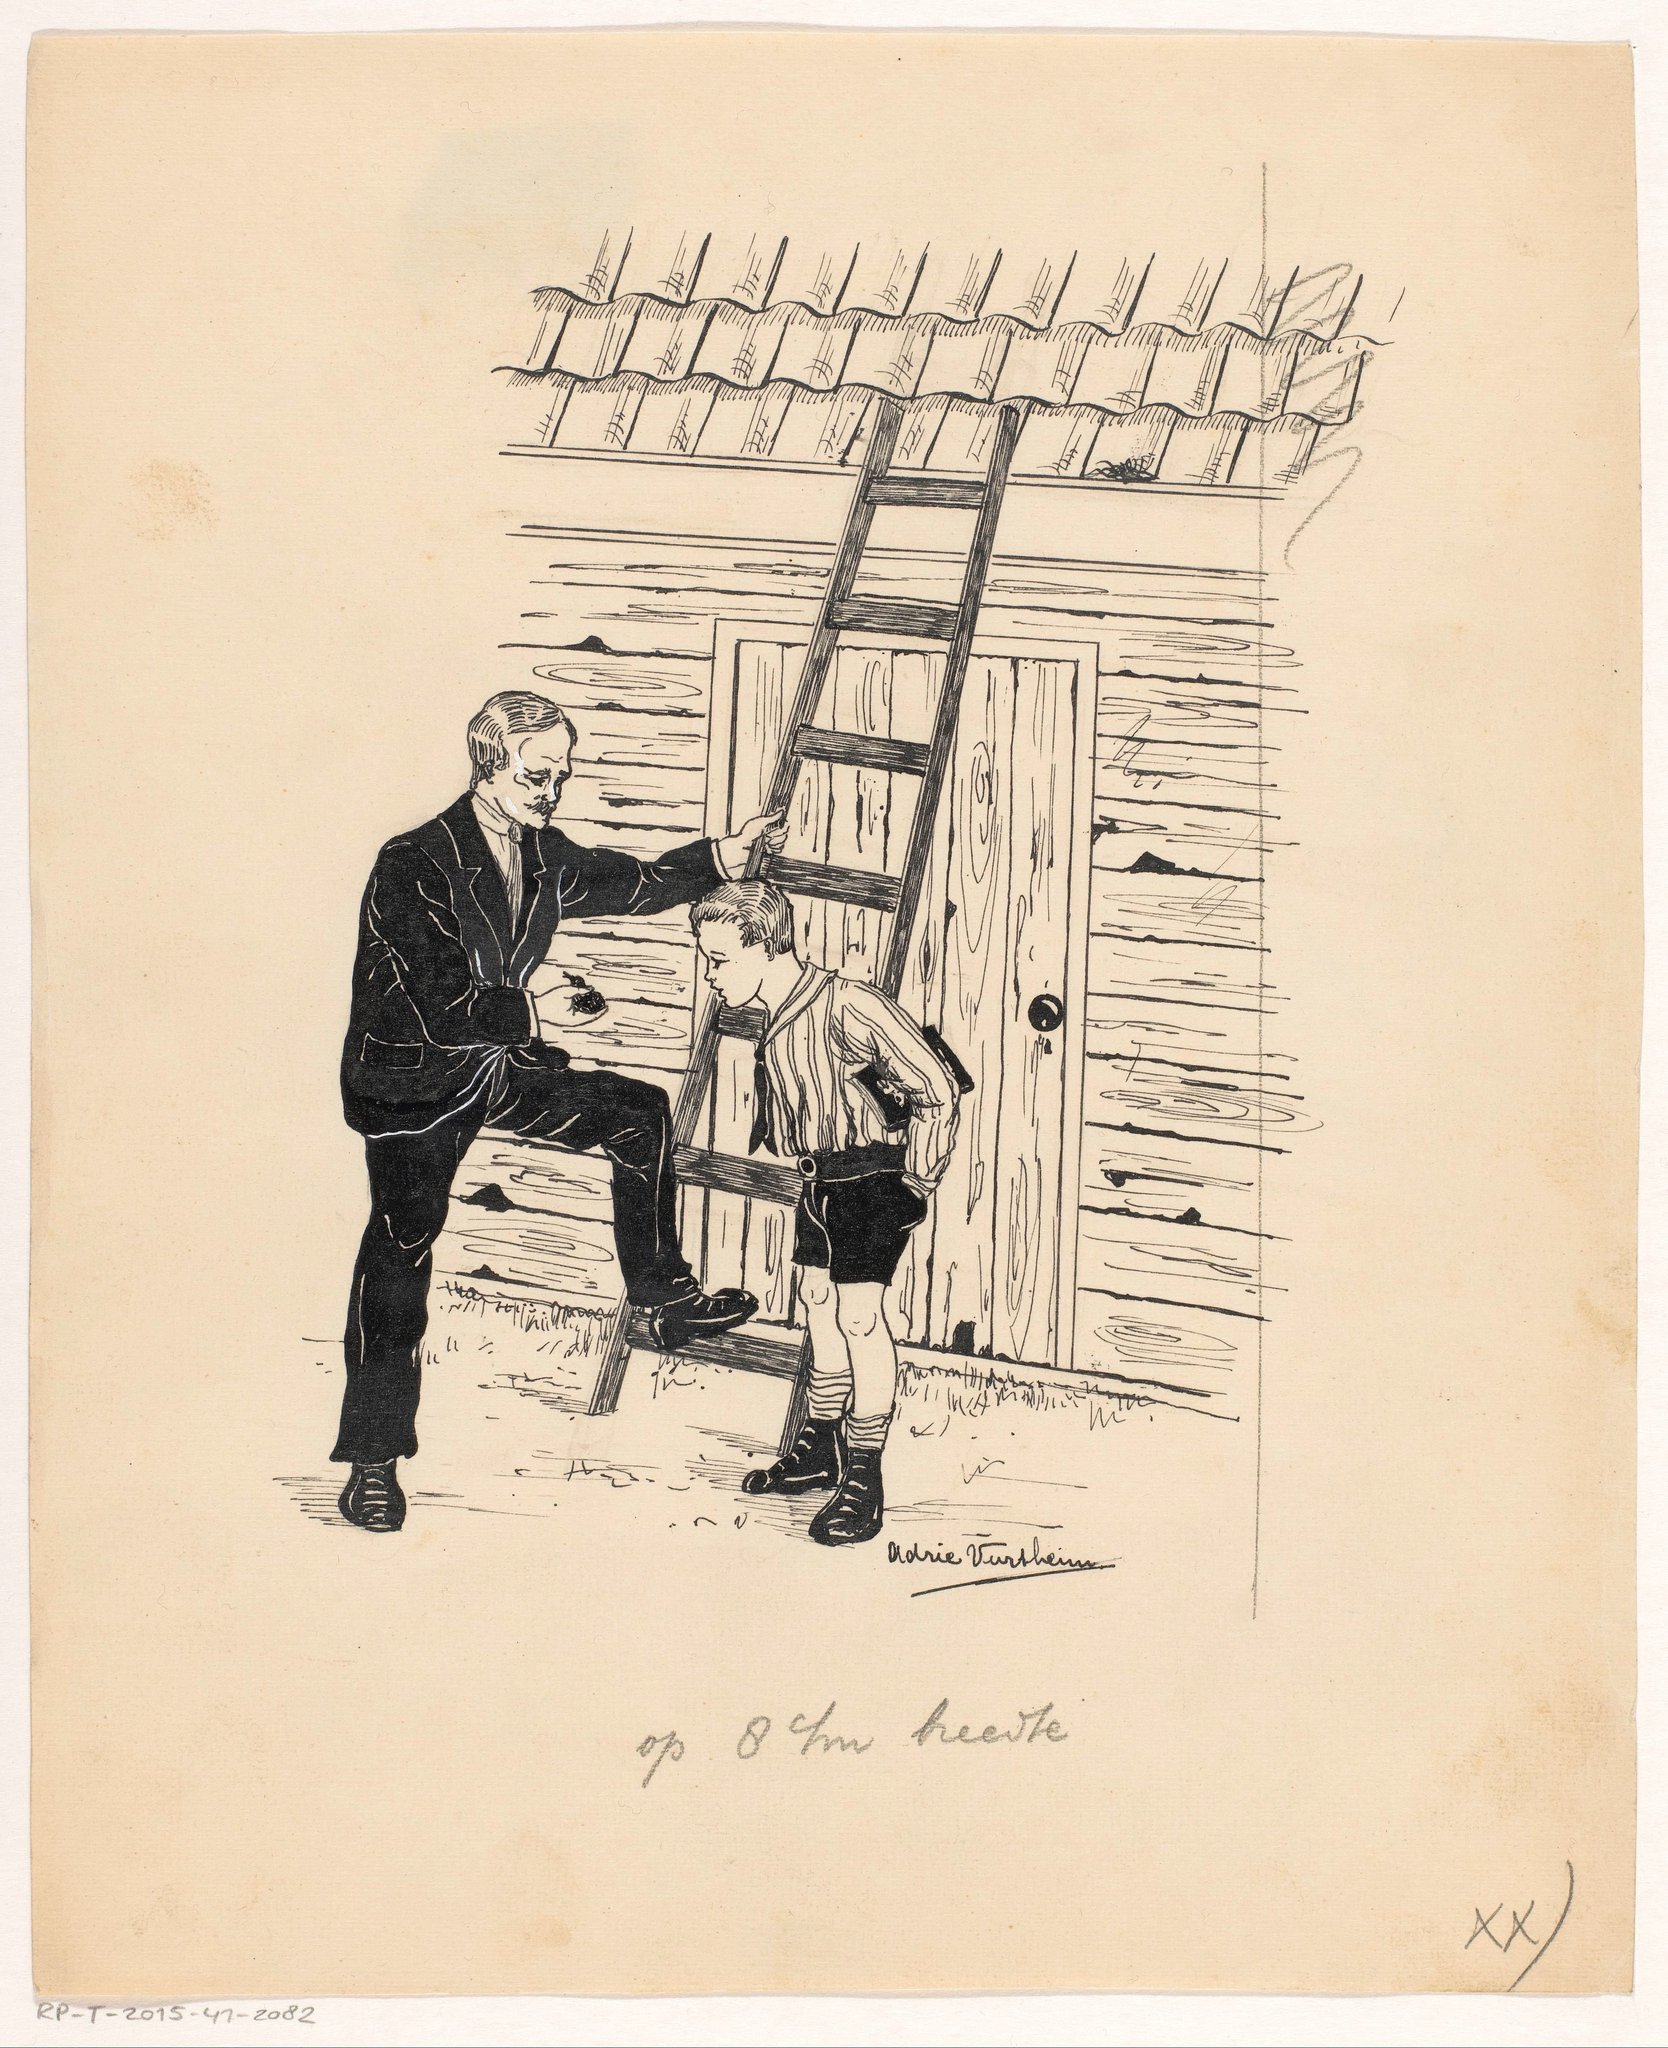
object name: boekillustratie ontwerp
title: Man en jongen met een vogel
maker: adrie vürtheim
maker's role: draughtsman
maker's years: 1907-1995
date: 1917-1970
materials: paint, ink, paper, pencil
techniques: brush, pen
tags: barn, birds, ladder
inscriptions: :, signature: ‘Adrie Vürtheim.’, collector's mark: Lugt 2228a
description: Een man en jongen staan naast een ladder bij een schuur. De jongen kijkt naar een vogel die de man in zijn hand heeft. Vermoedelijk heeft de man de vogel met behulp van de ladder uit de dakgoot gehaald.